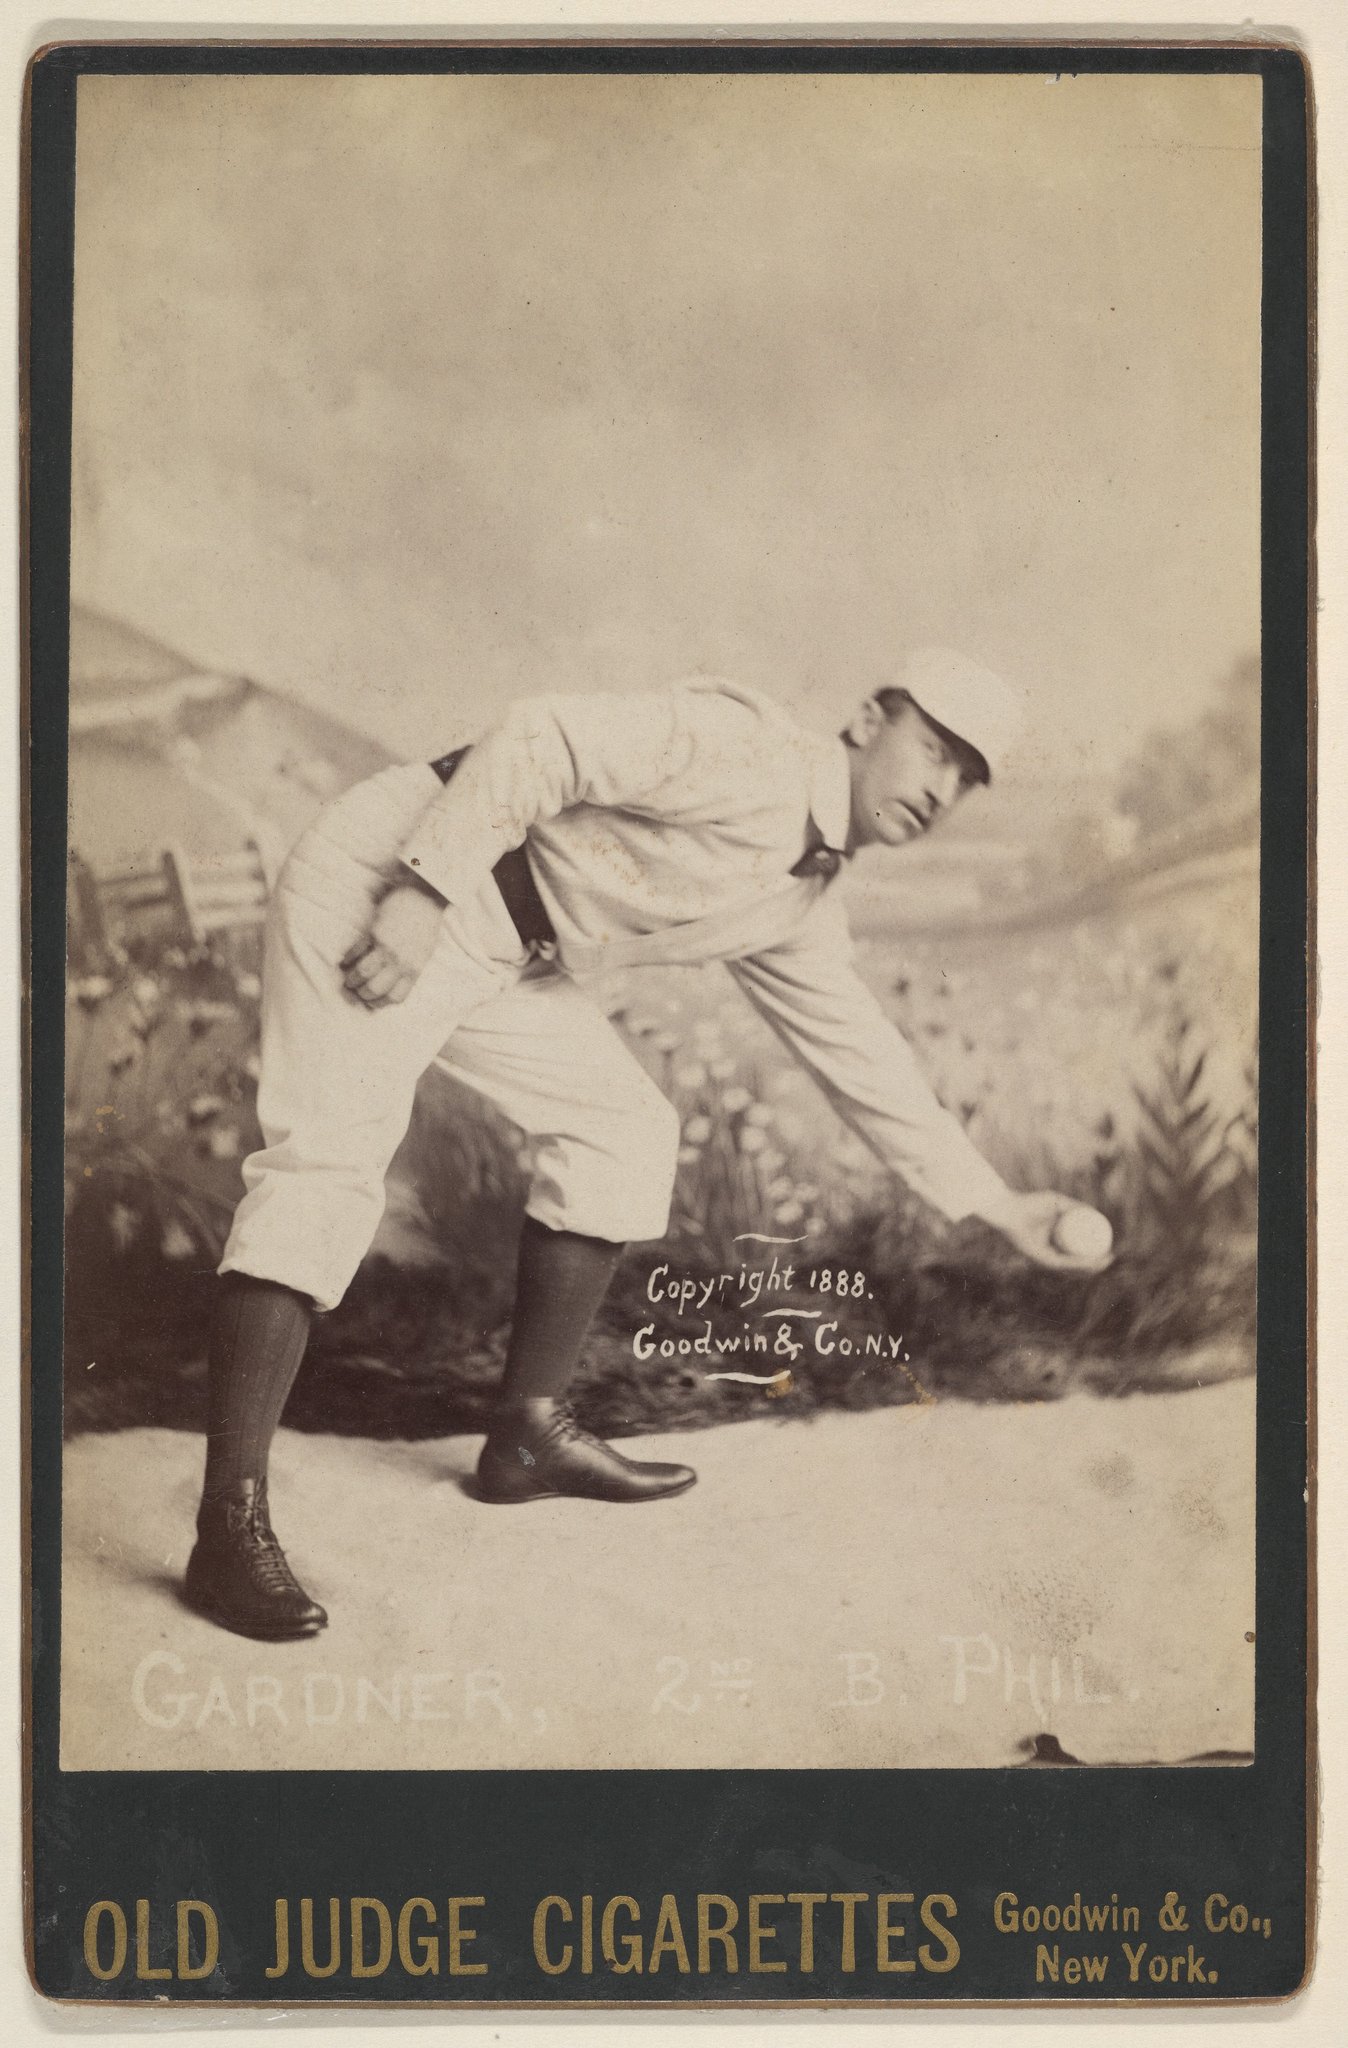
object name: baseball card, photograph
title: Gardner, 2nd Base, Philadelphia, from the series Old Judge Cigarettes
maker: goodwin & company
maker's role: publisher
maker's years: 1850-1950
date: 1888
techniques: albumen silver print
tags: men,portraits,baseball,athletes